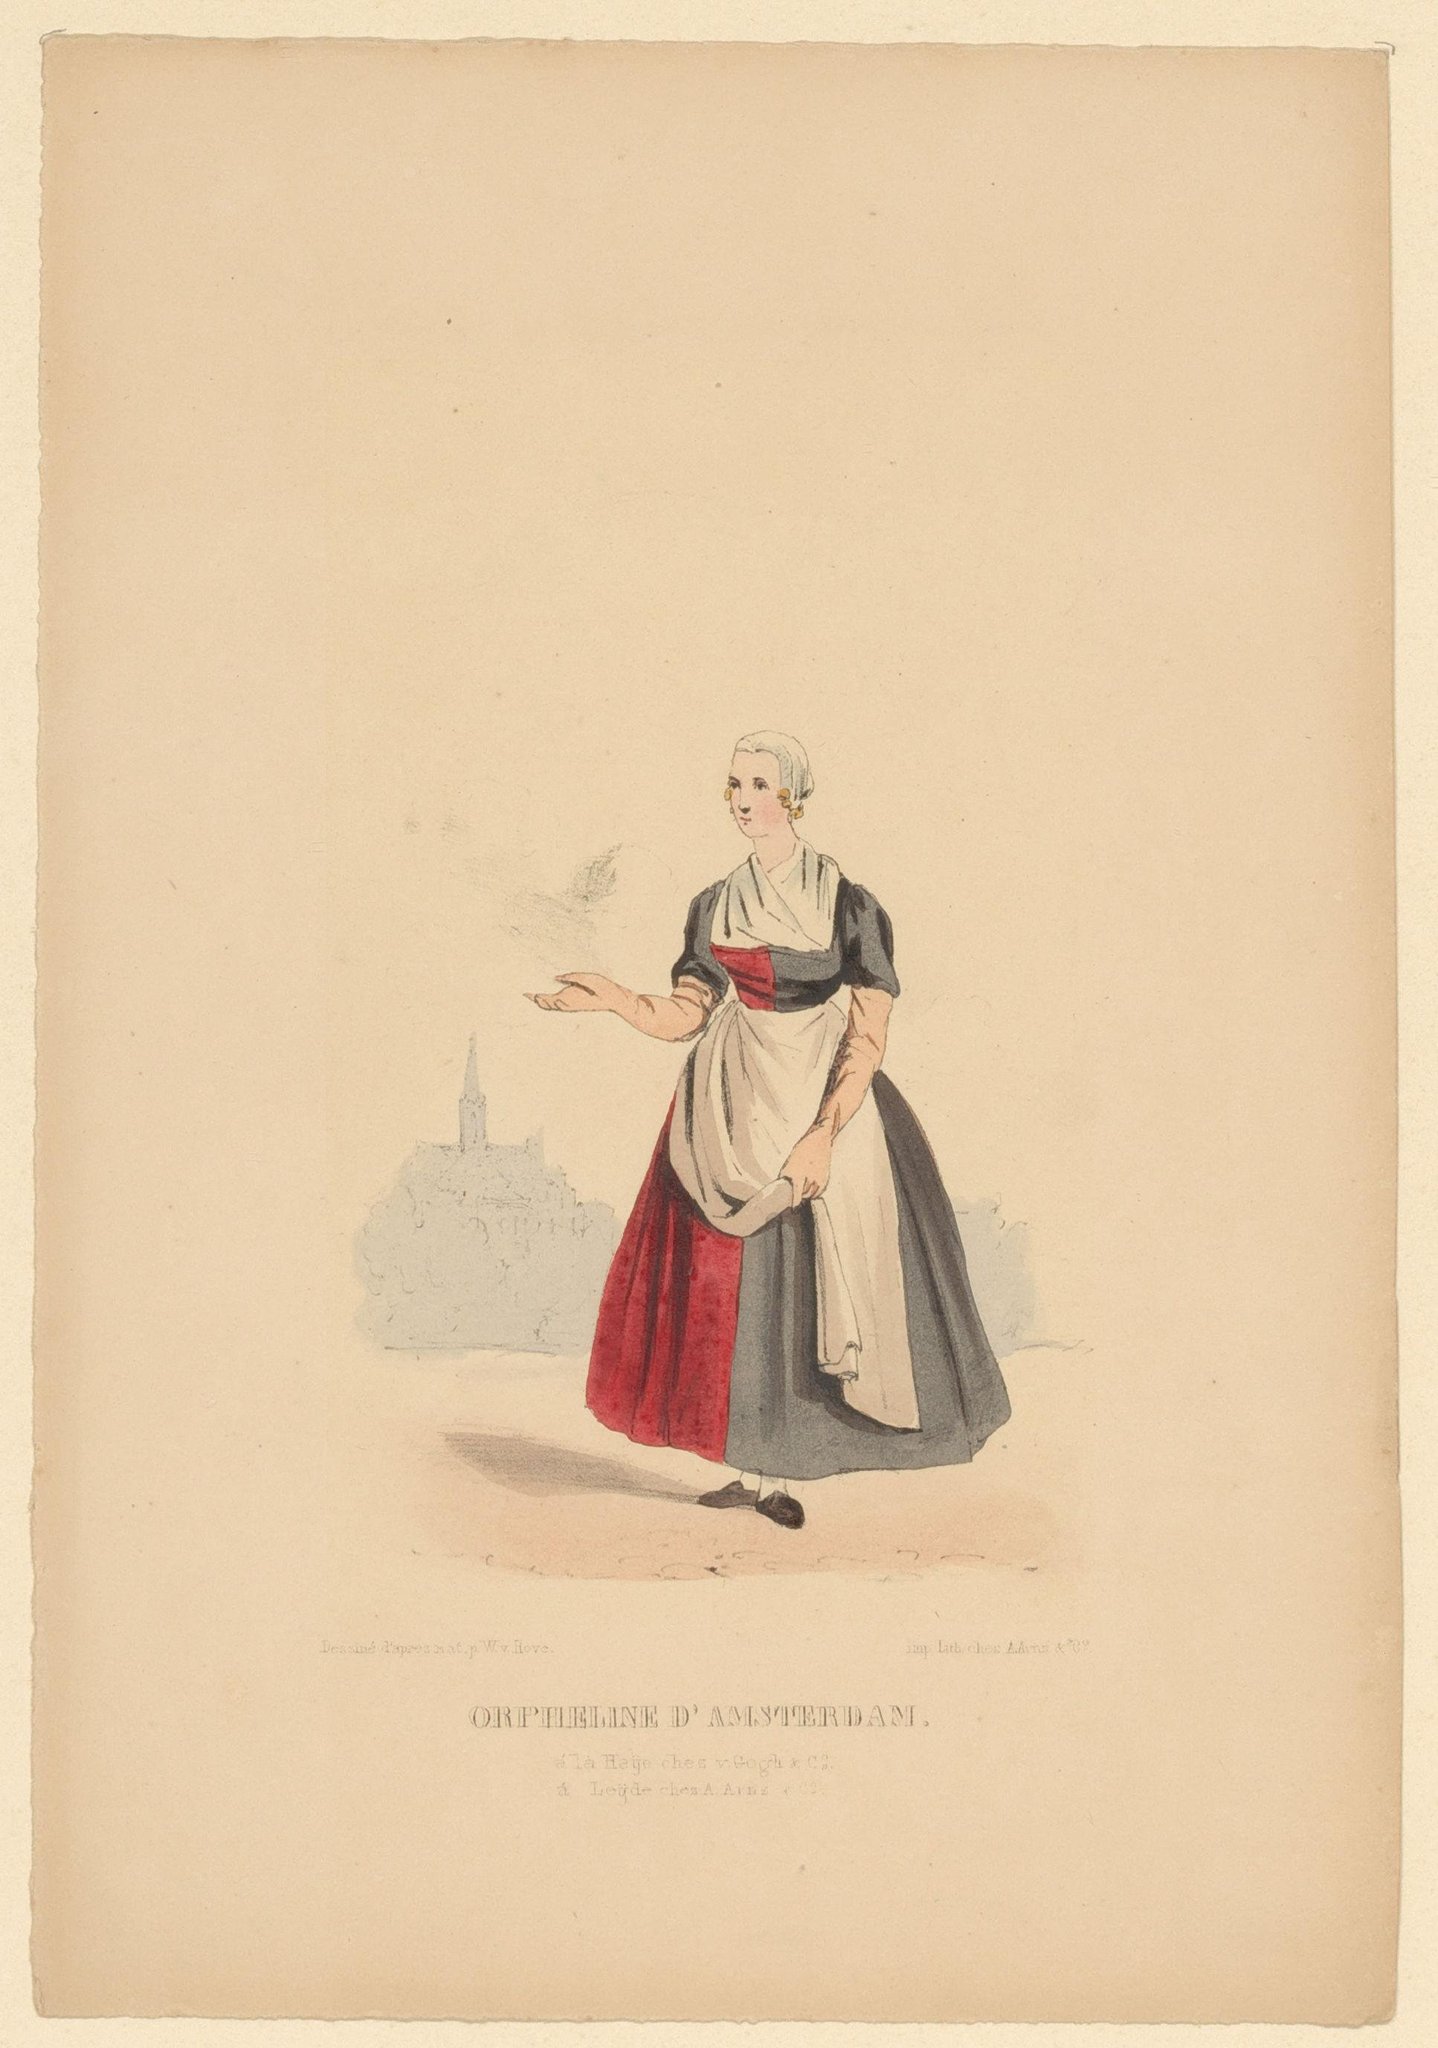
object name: print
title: Orpheline d'Amsterdam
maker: w. van hove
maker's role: draughtsman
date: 1840-1853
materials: paper, watercolor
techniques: lithograph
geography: leiden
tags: public welfare, folk costume, regional costume, orphans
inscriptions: collector's mark: Lugt 1641, collector's mark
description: Meisje van het Amsterdamse Burgerweeshuis. Onderwerpsrubrieken binnen de Atlas Zeden en Gewoonten: Armwezen en Liefdadigheid.